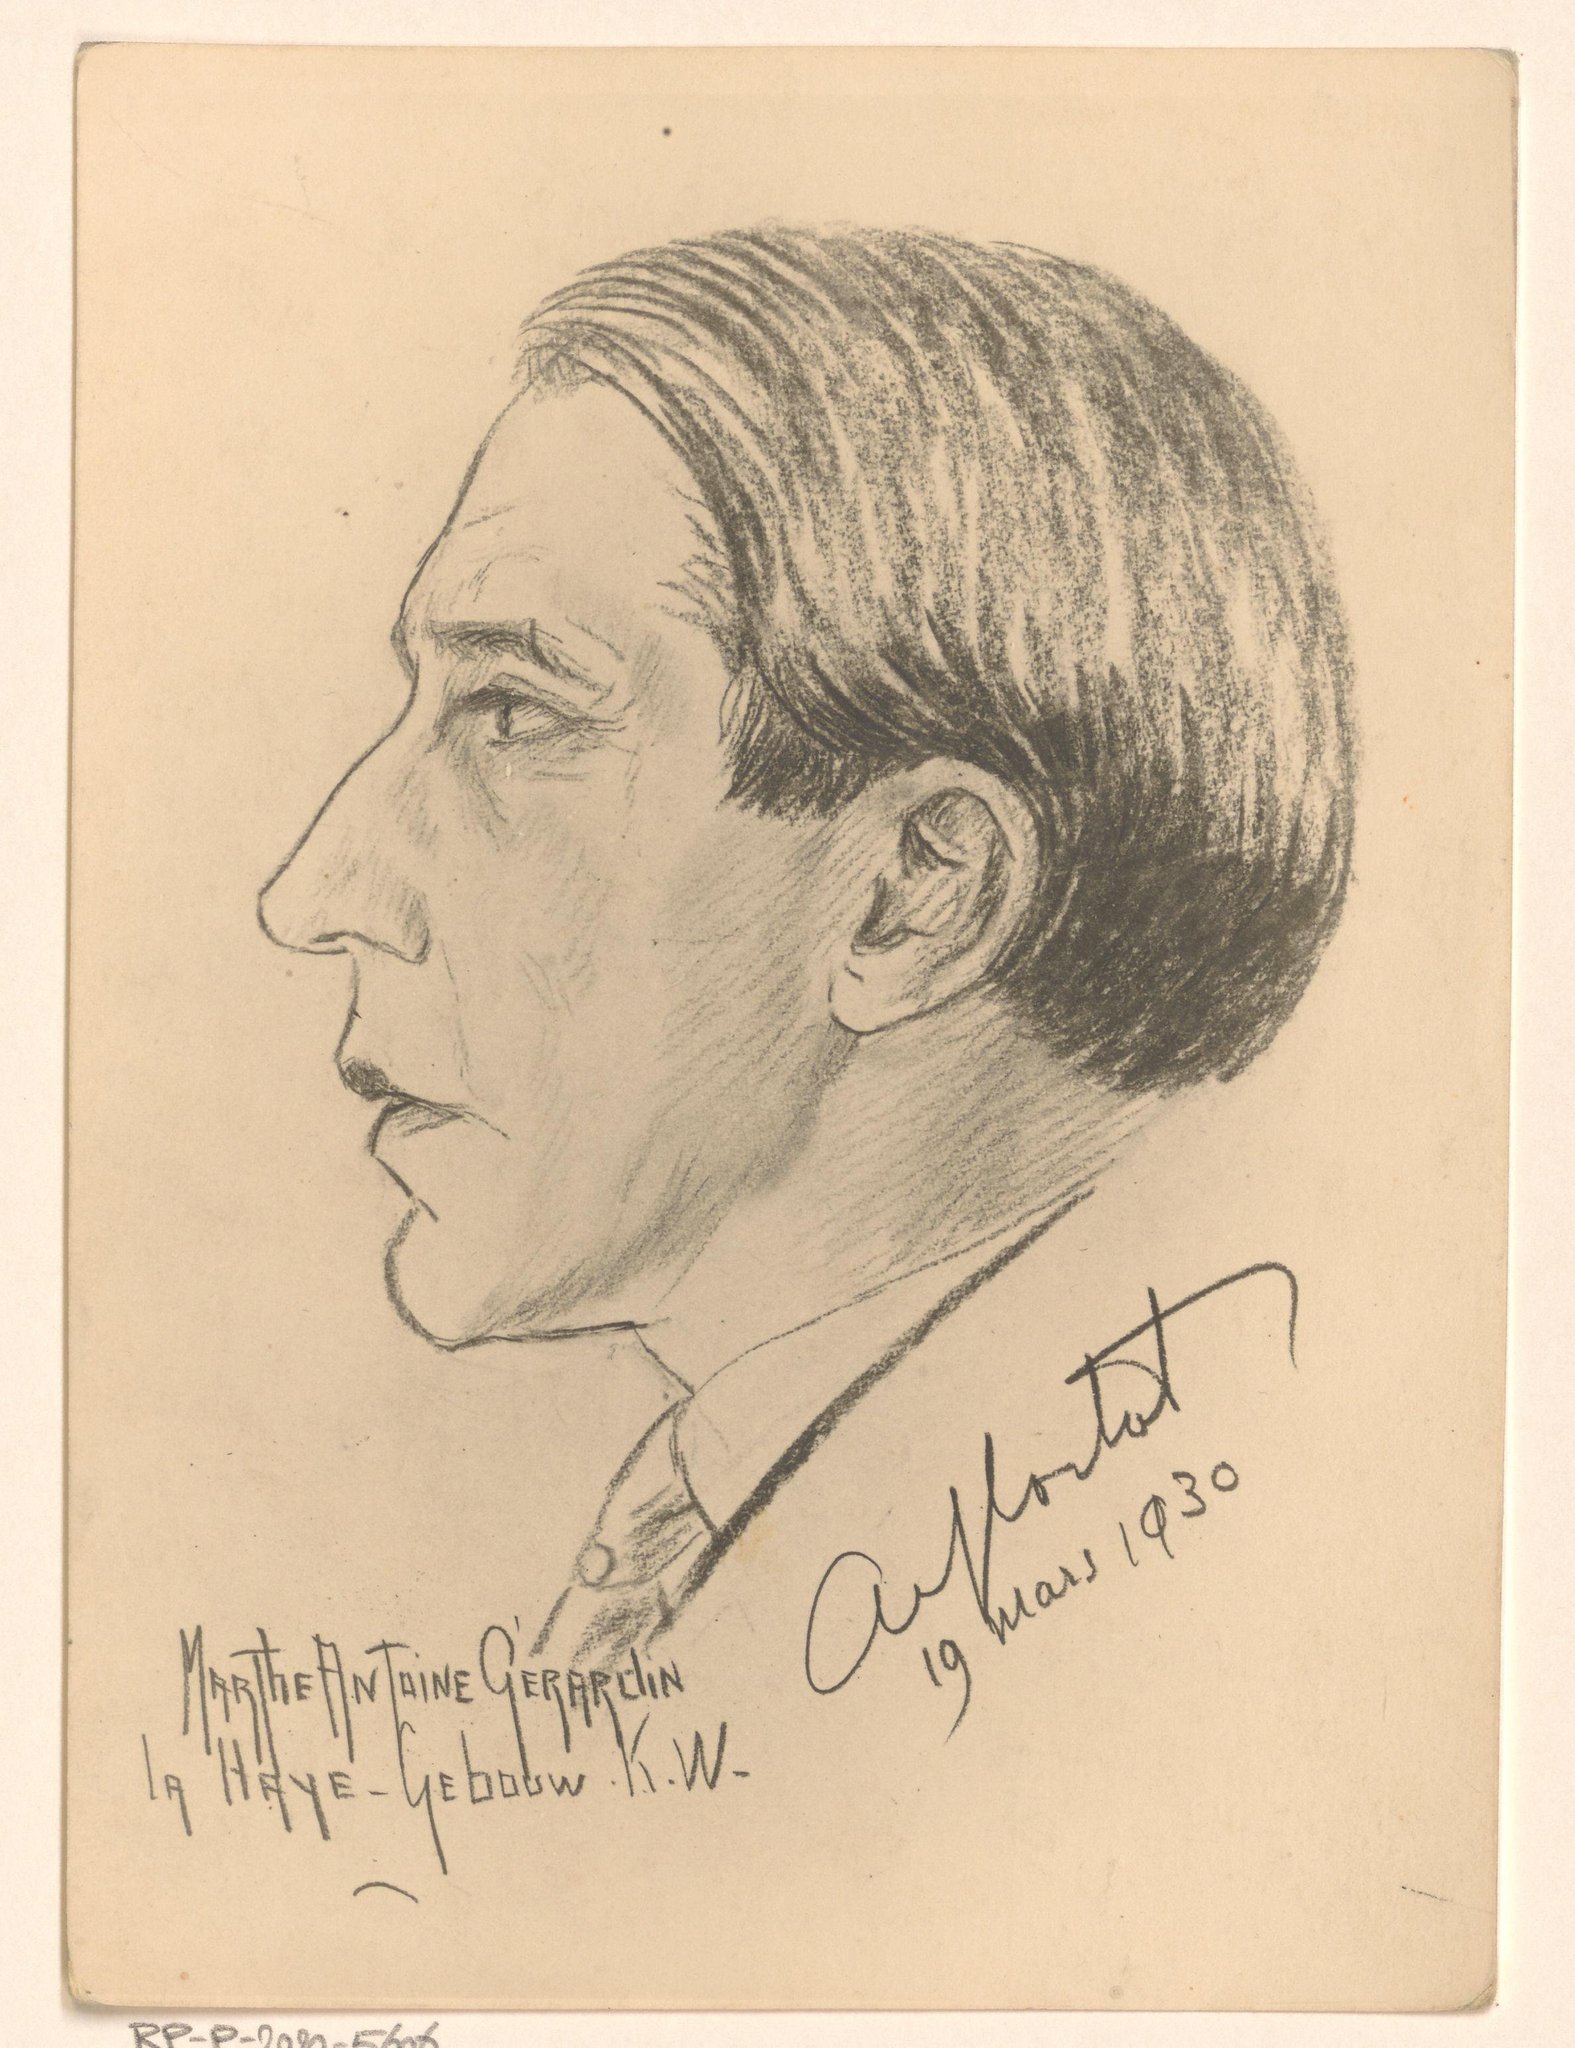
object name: print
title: Portret van Alfred Cortot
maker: marthe antoine gérardin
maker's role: draughtsman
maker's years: 1884-1952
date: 1930-1952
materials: paper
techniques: lithograph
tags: historical persons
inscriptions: : Lugt 2228